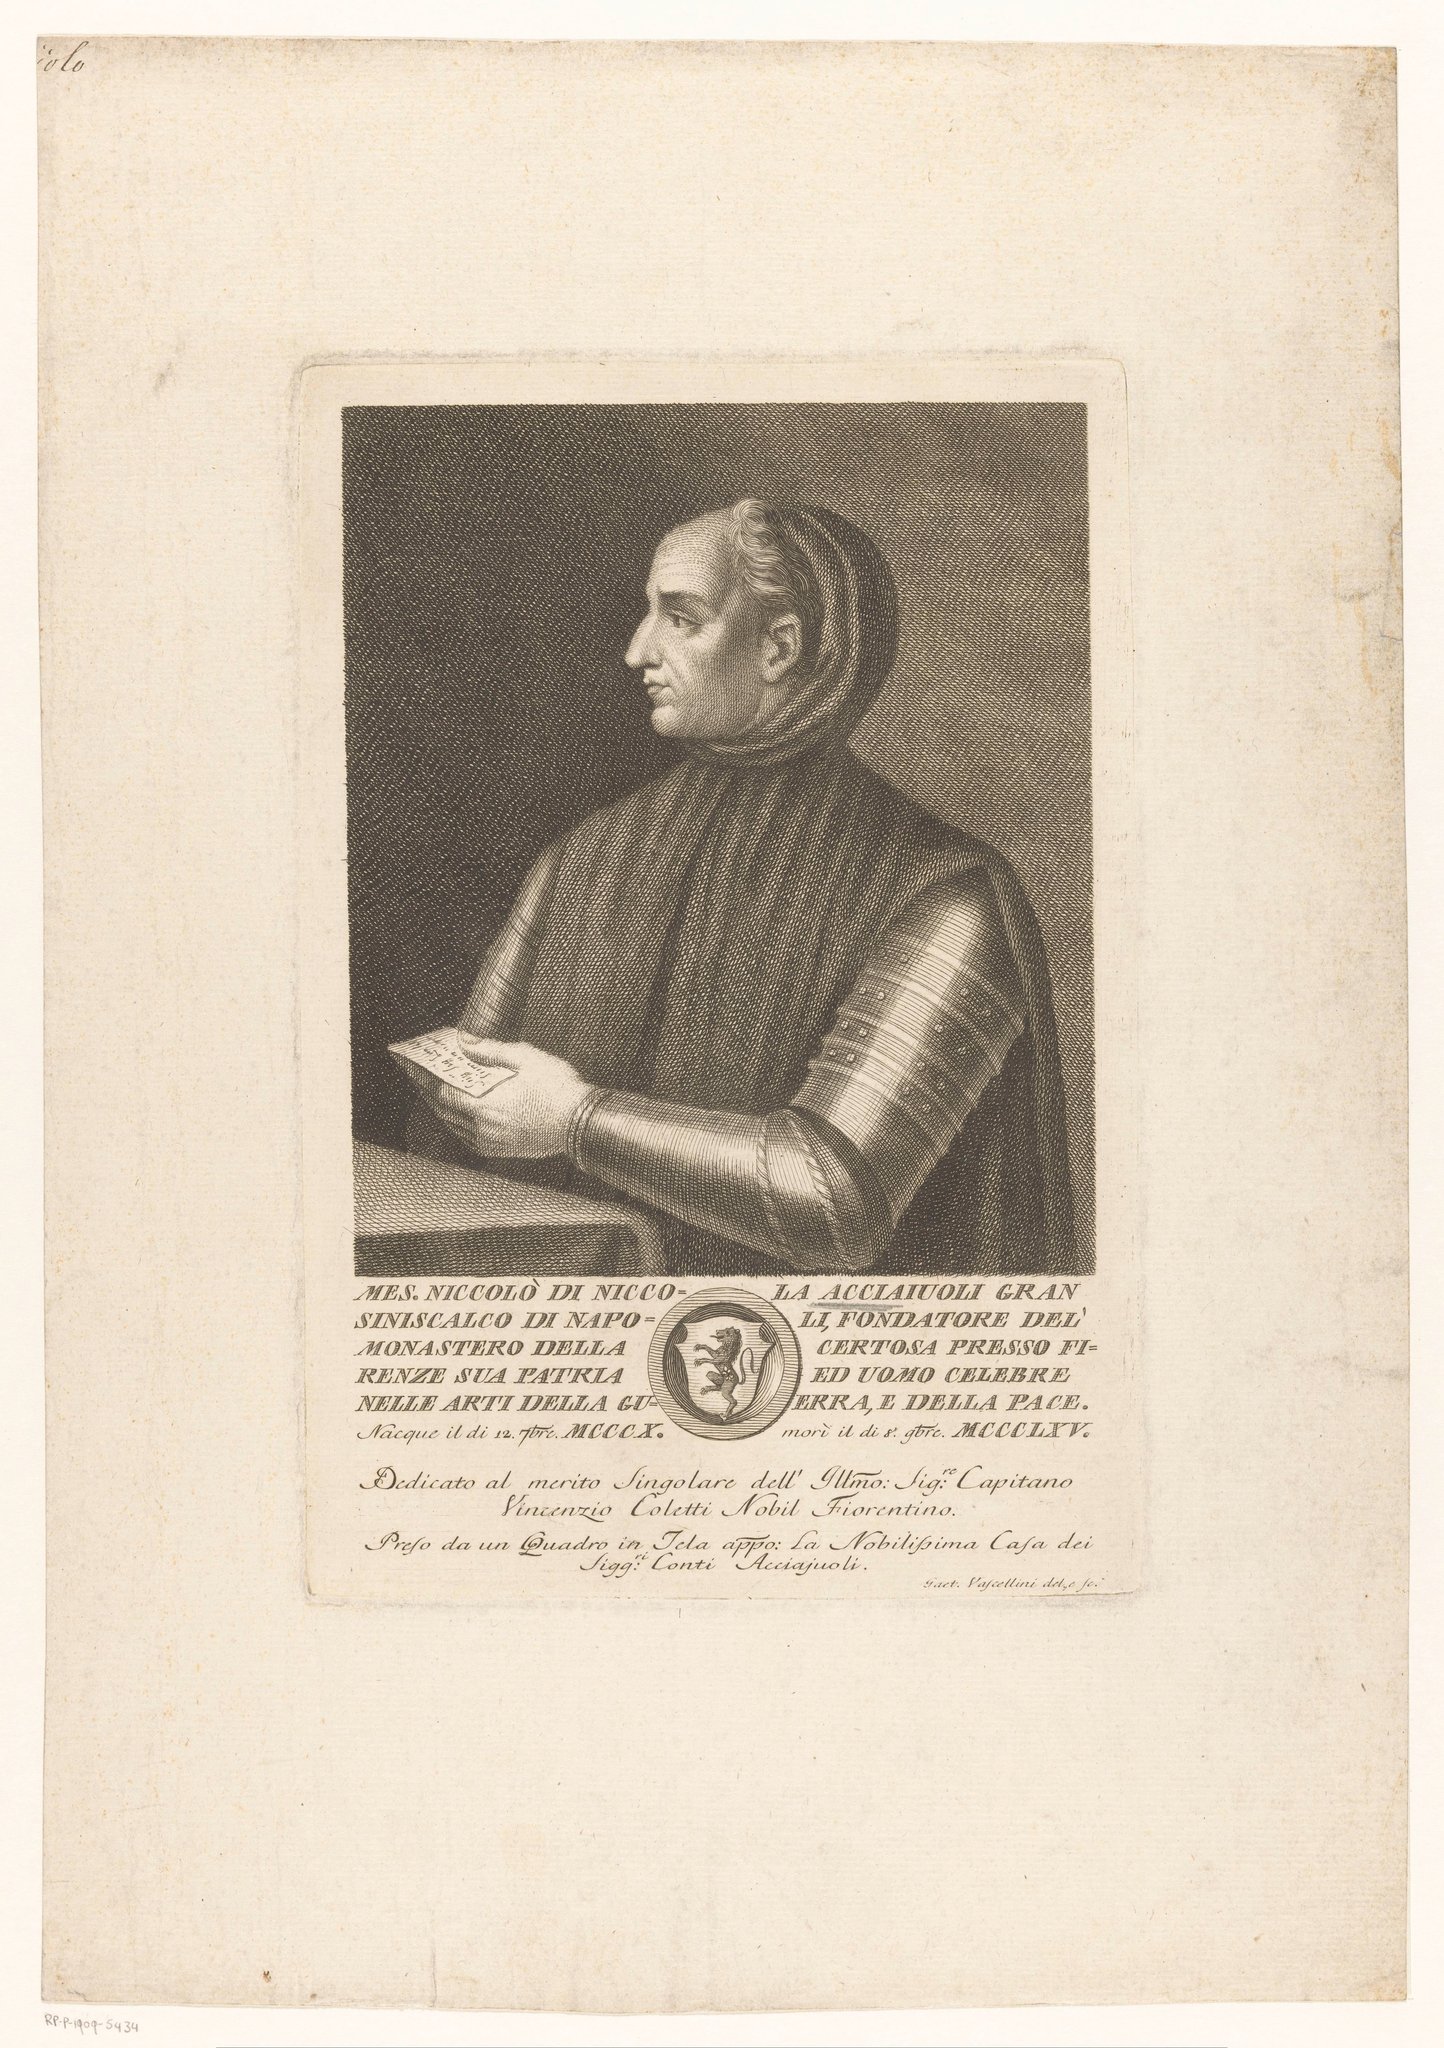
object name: print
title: Portret van politicus Niccolò Acciaiuoli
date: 1755-1805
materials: paper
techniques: engraving, etching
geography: italy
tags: naples, politician, historical persons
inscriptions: inscription: ‘[...] iolo’, collector's mark: Lugt 2228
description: Onder het portret een tekst in het Italiaans en een wapenschild in een cirkelvormig kader.